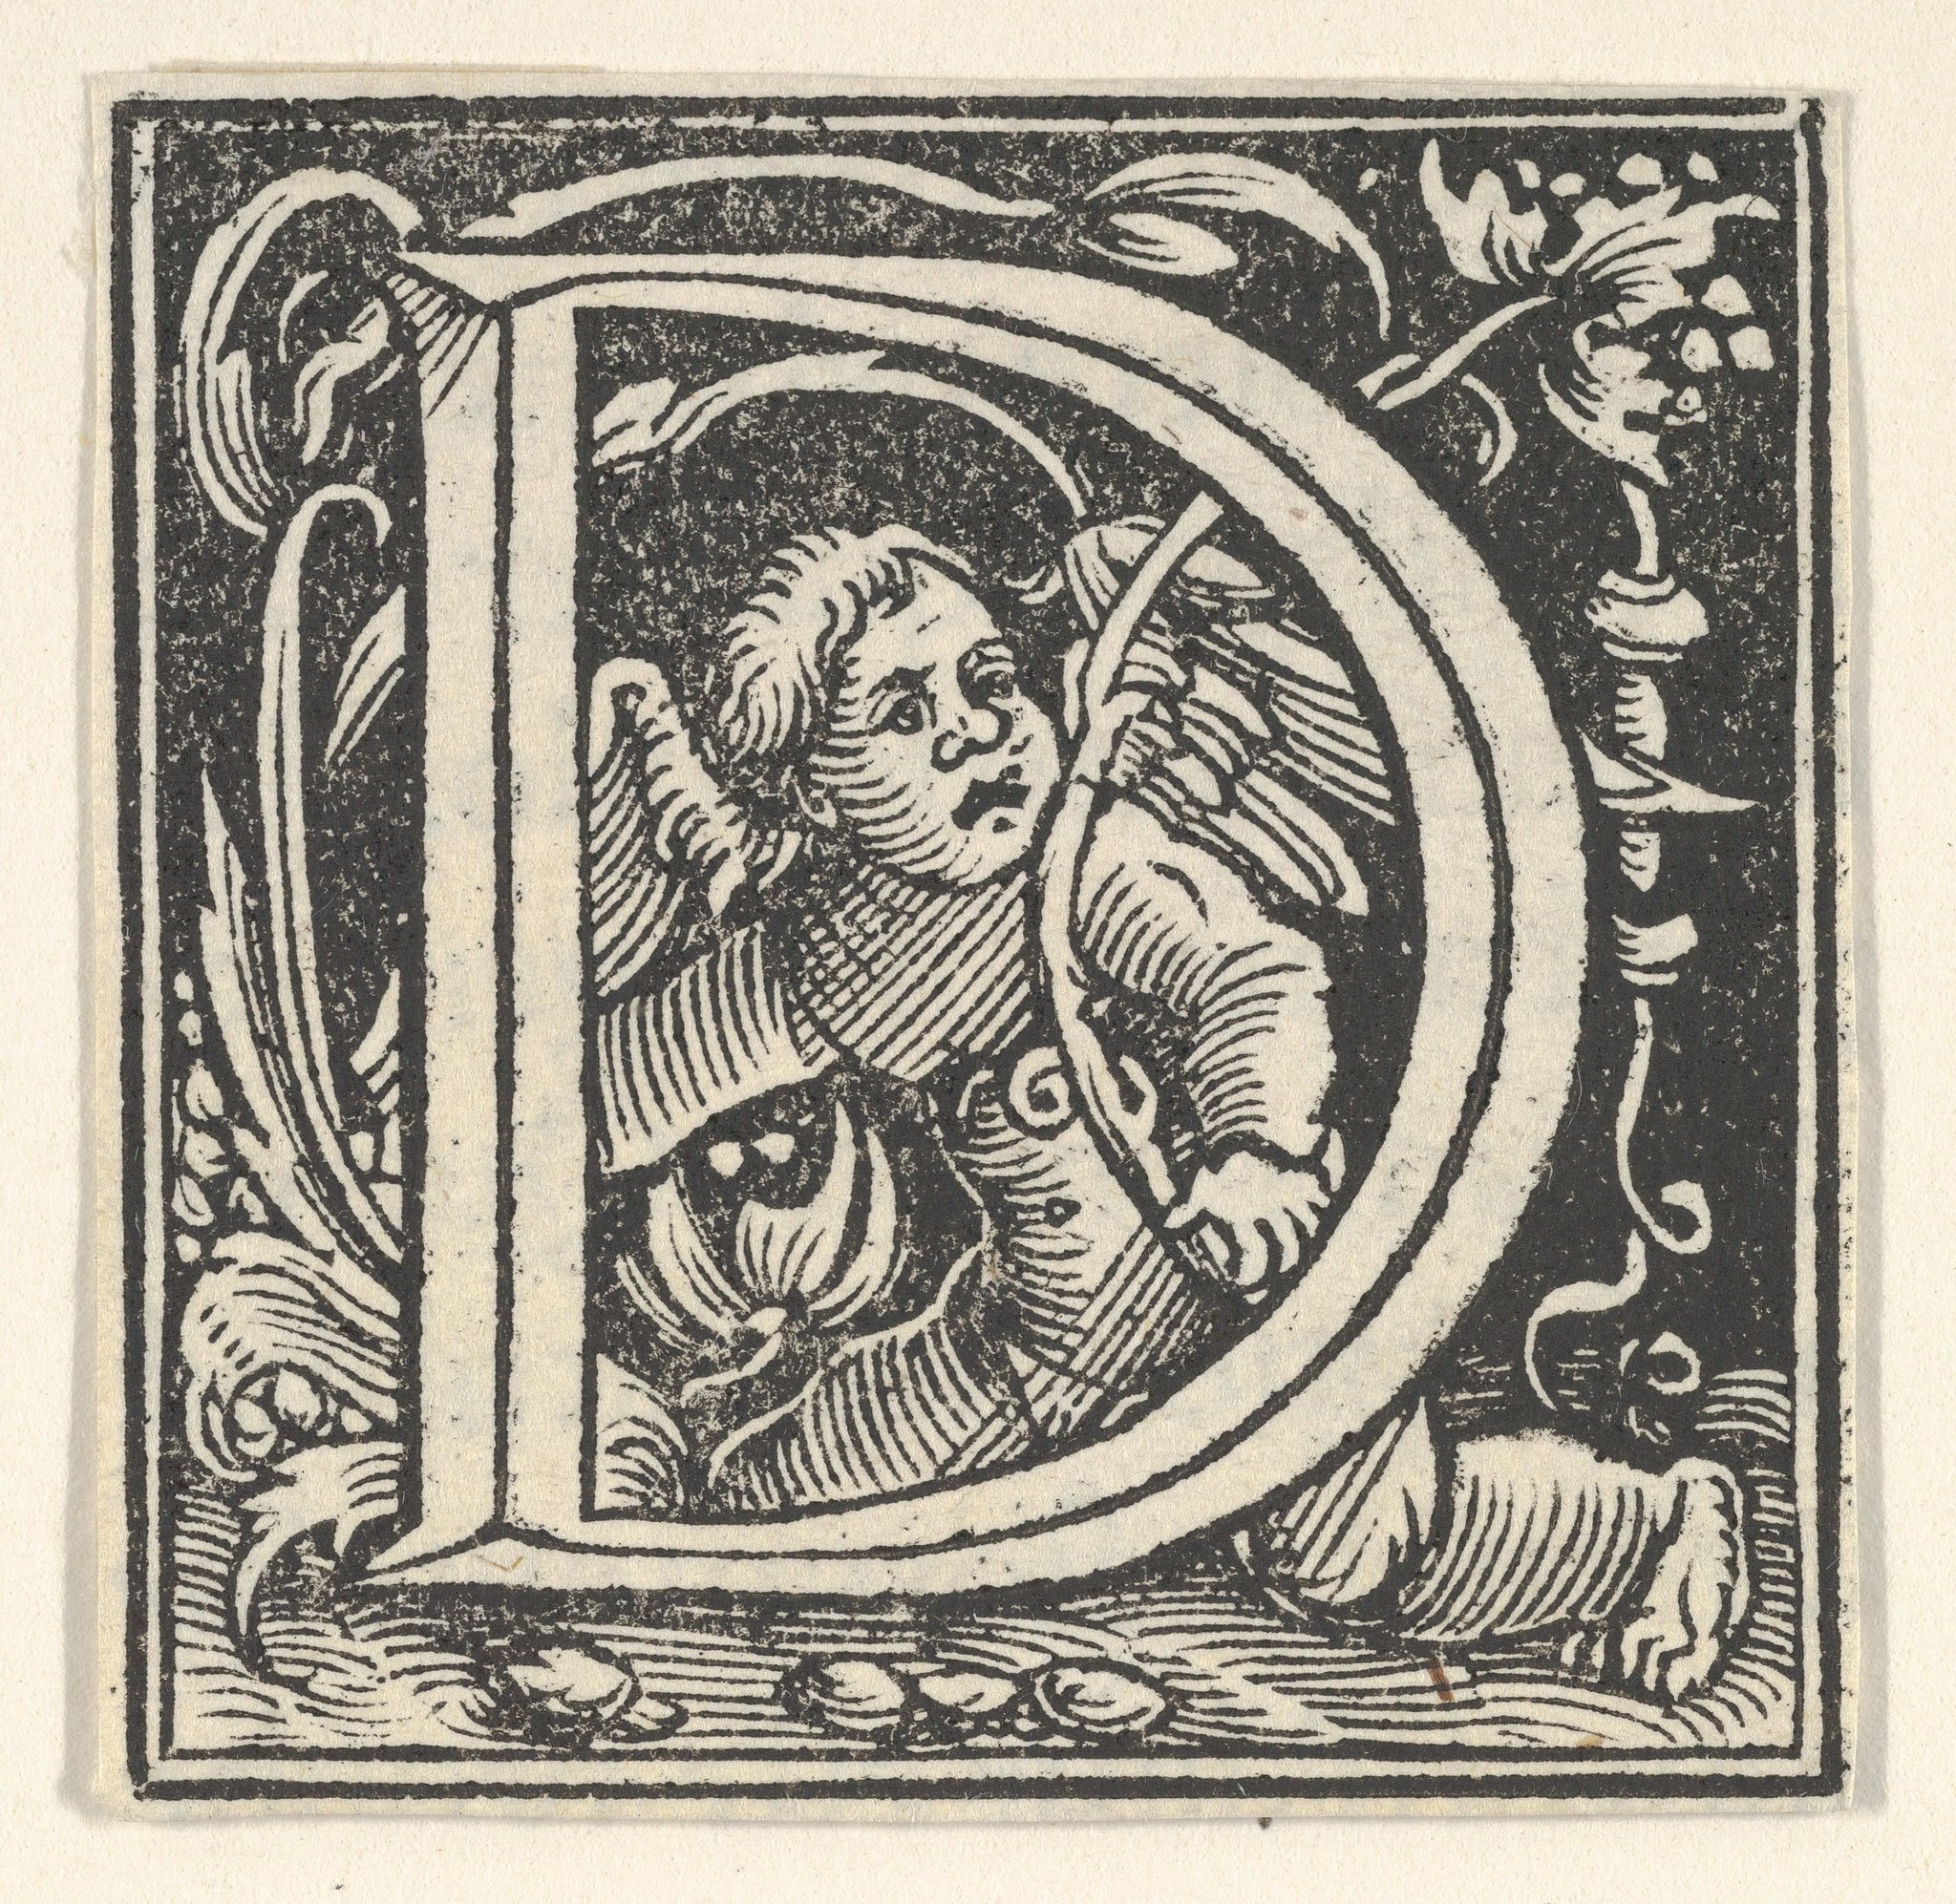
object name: print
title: Initial letter D with putto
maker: heinrich vogtherr the elder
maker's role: artist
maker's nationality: german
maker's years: 1538-1540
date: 1538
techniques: woodcut